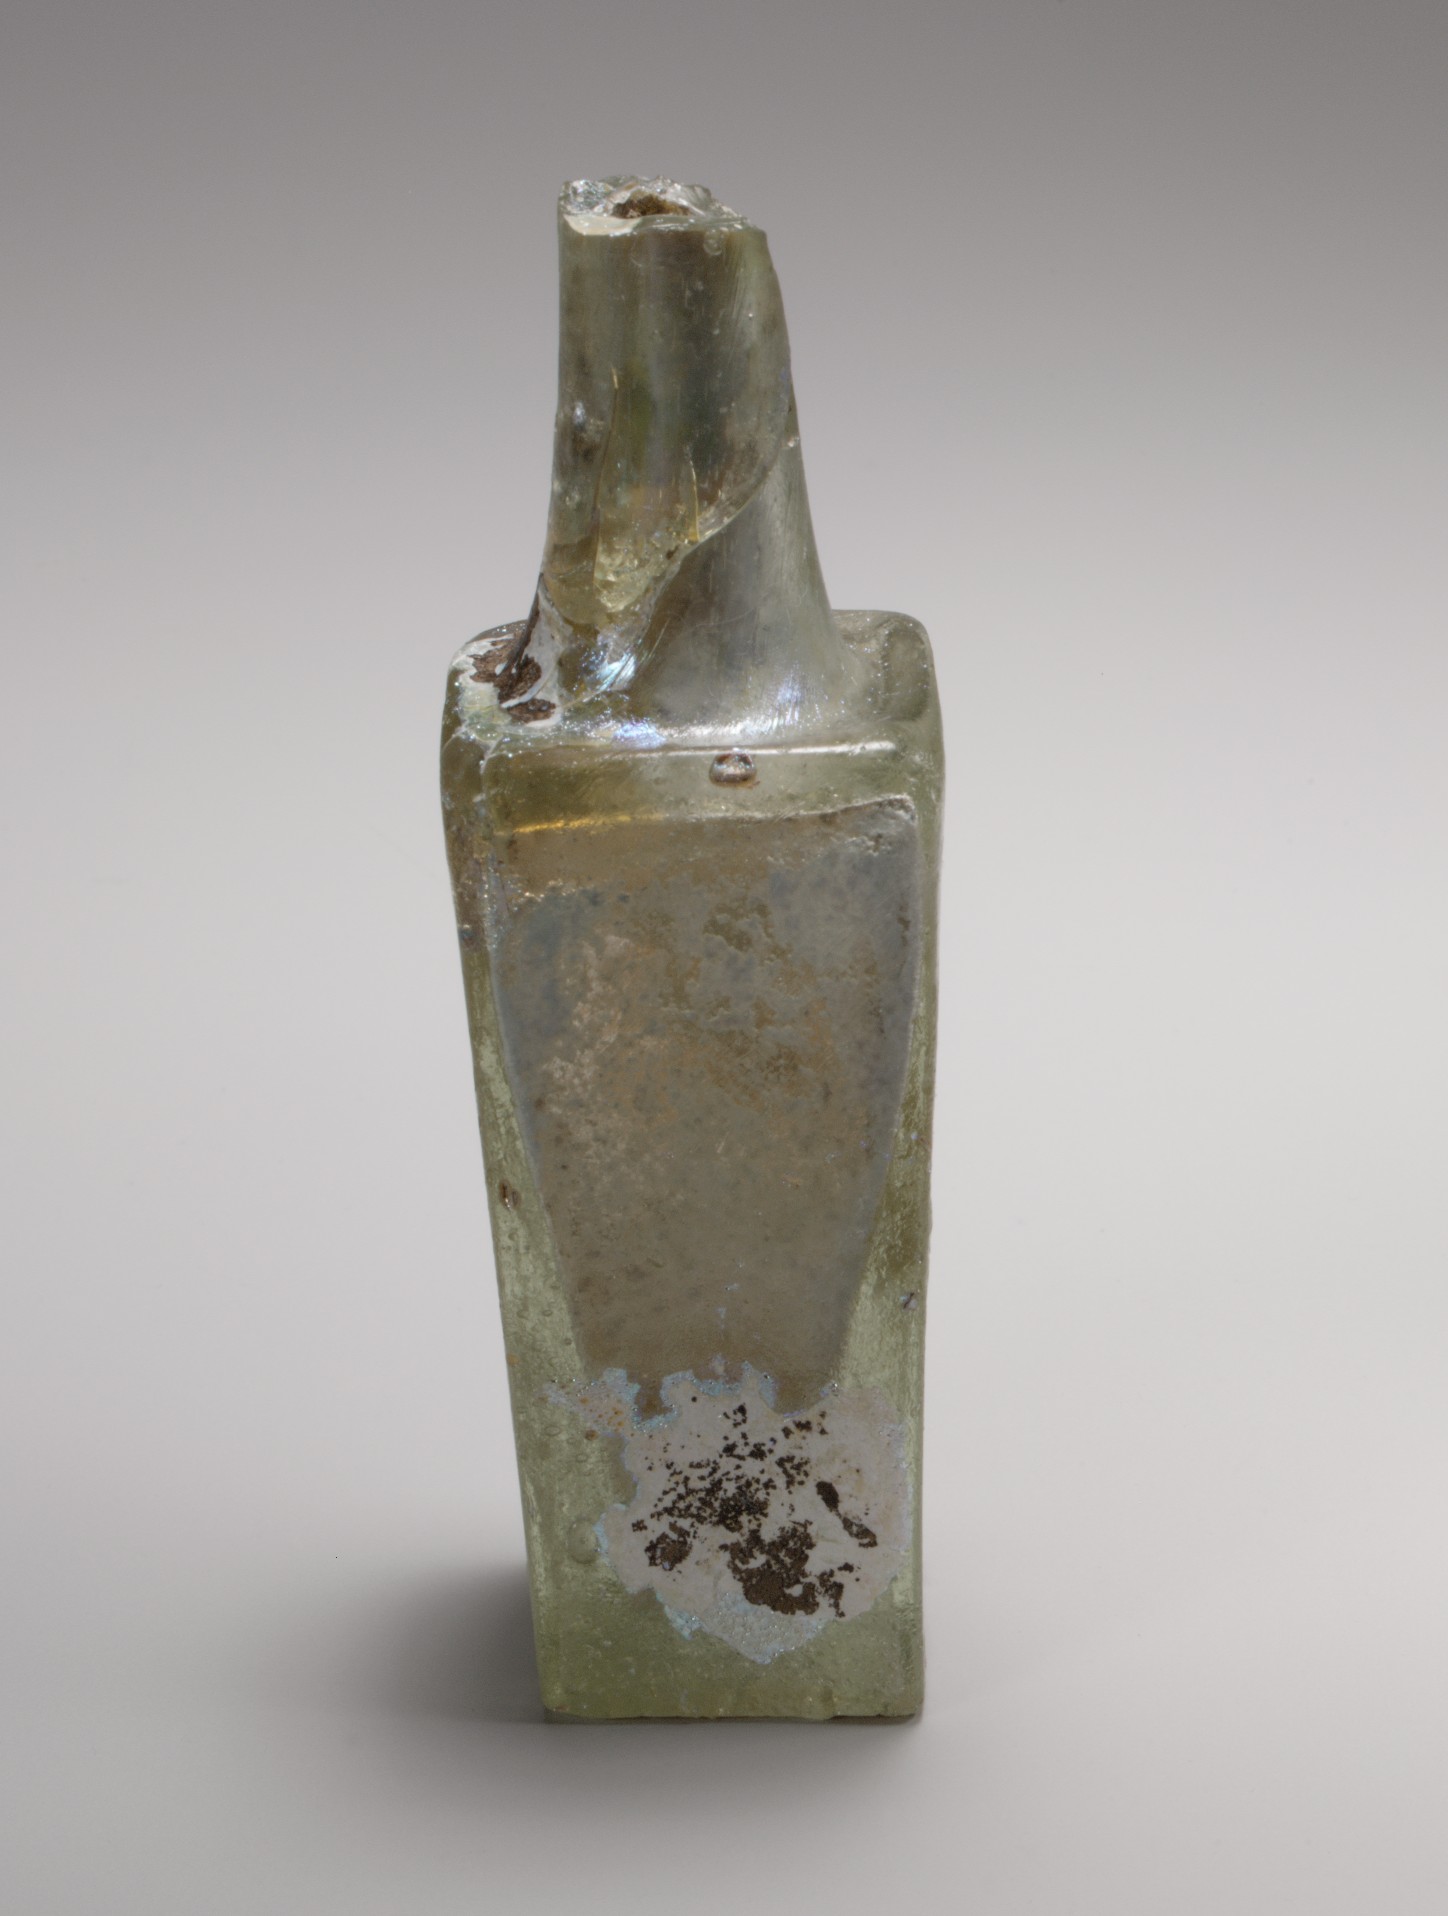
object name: bottle, mercury flask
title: Glass 'Mercury' bottle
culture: roman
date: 101-300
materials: glass